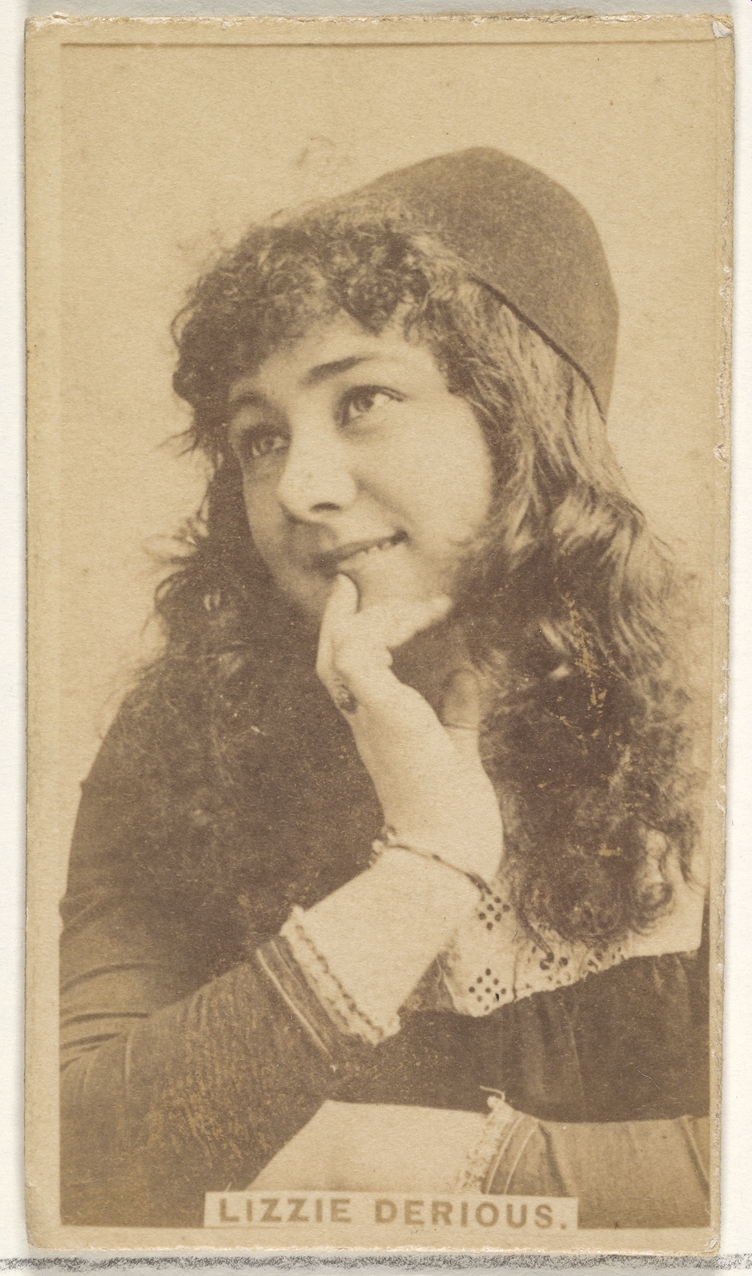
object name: photograph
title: Lizzie Derious, from the Actors and Actresses series (N45, Type 1) for Virginia Brights Cigarettes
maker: allen & ginter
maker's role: publisher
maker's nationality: american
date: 1888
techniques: albumen silver print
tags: portraits,women,actresses